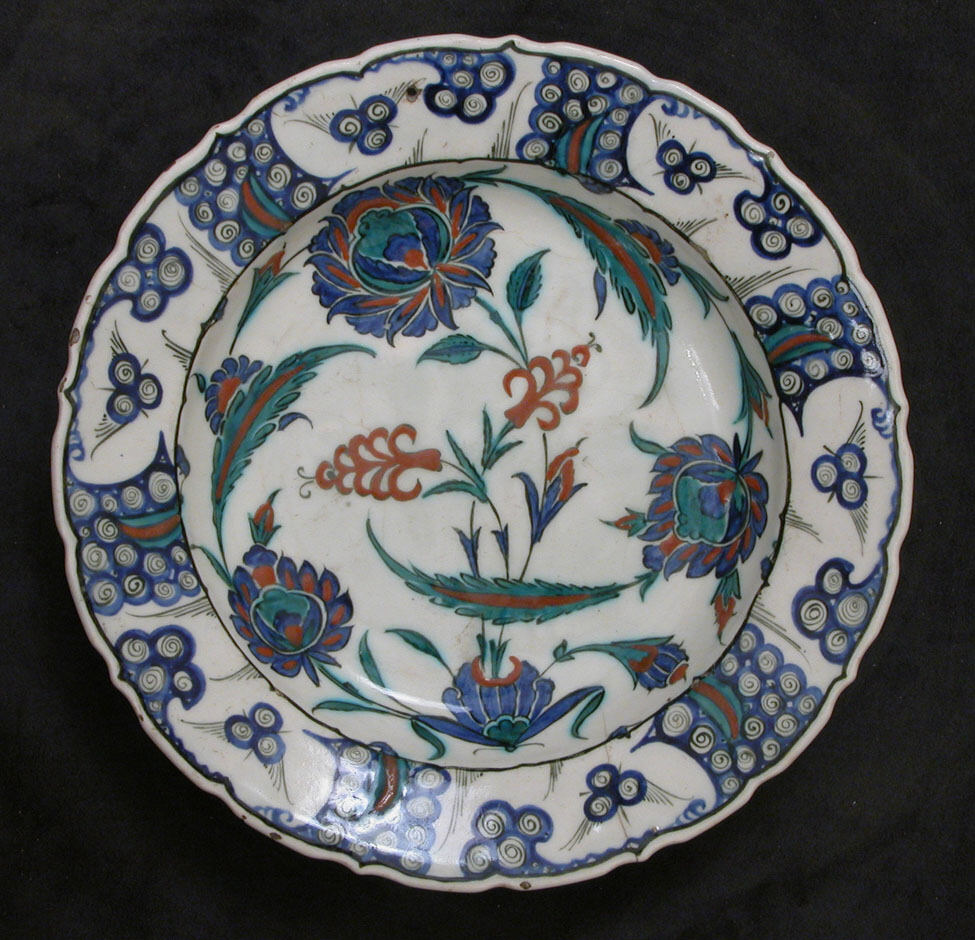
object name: dish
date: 1501-1600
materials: stonepaste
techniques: painting, underglaze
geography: turkey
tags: flowers